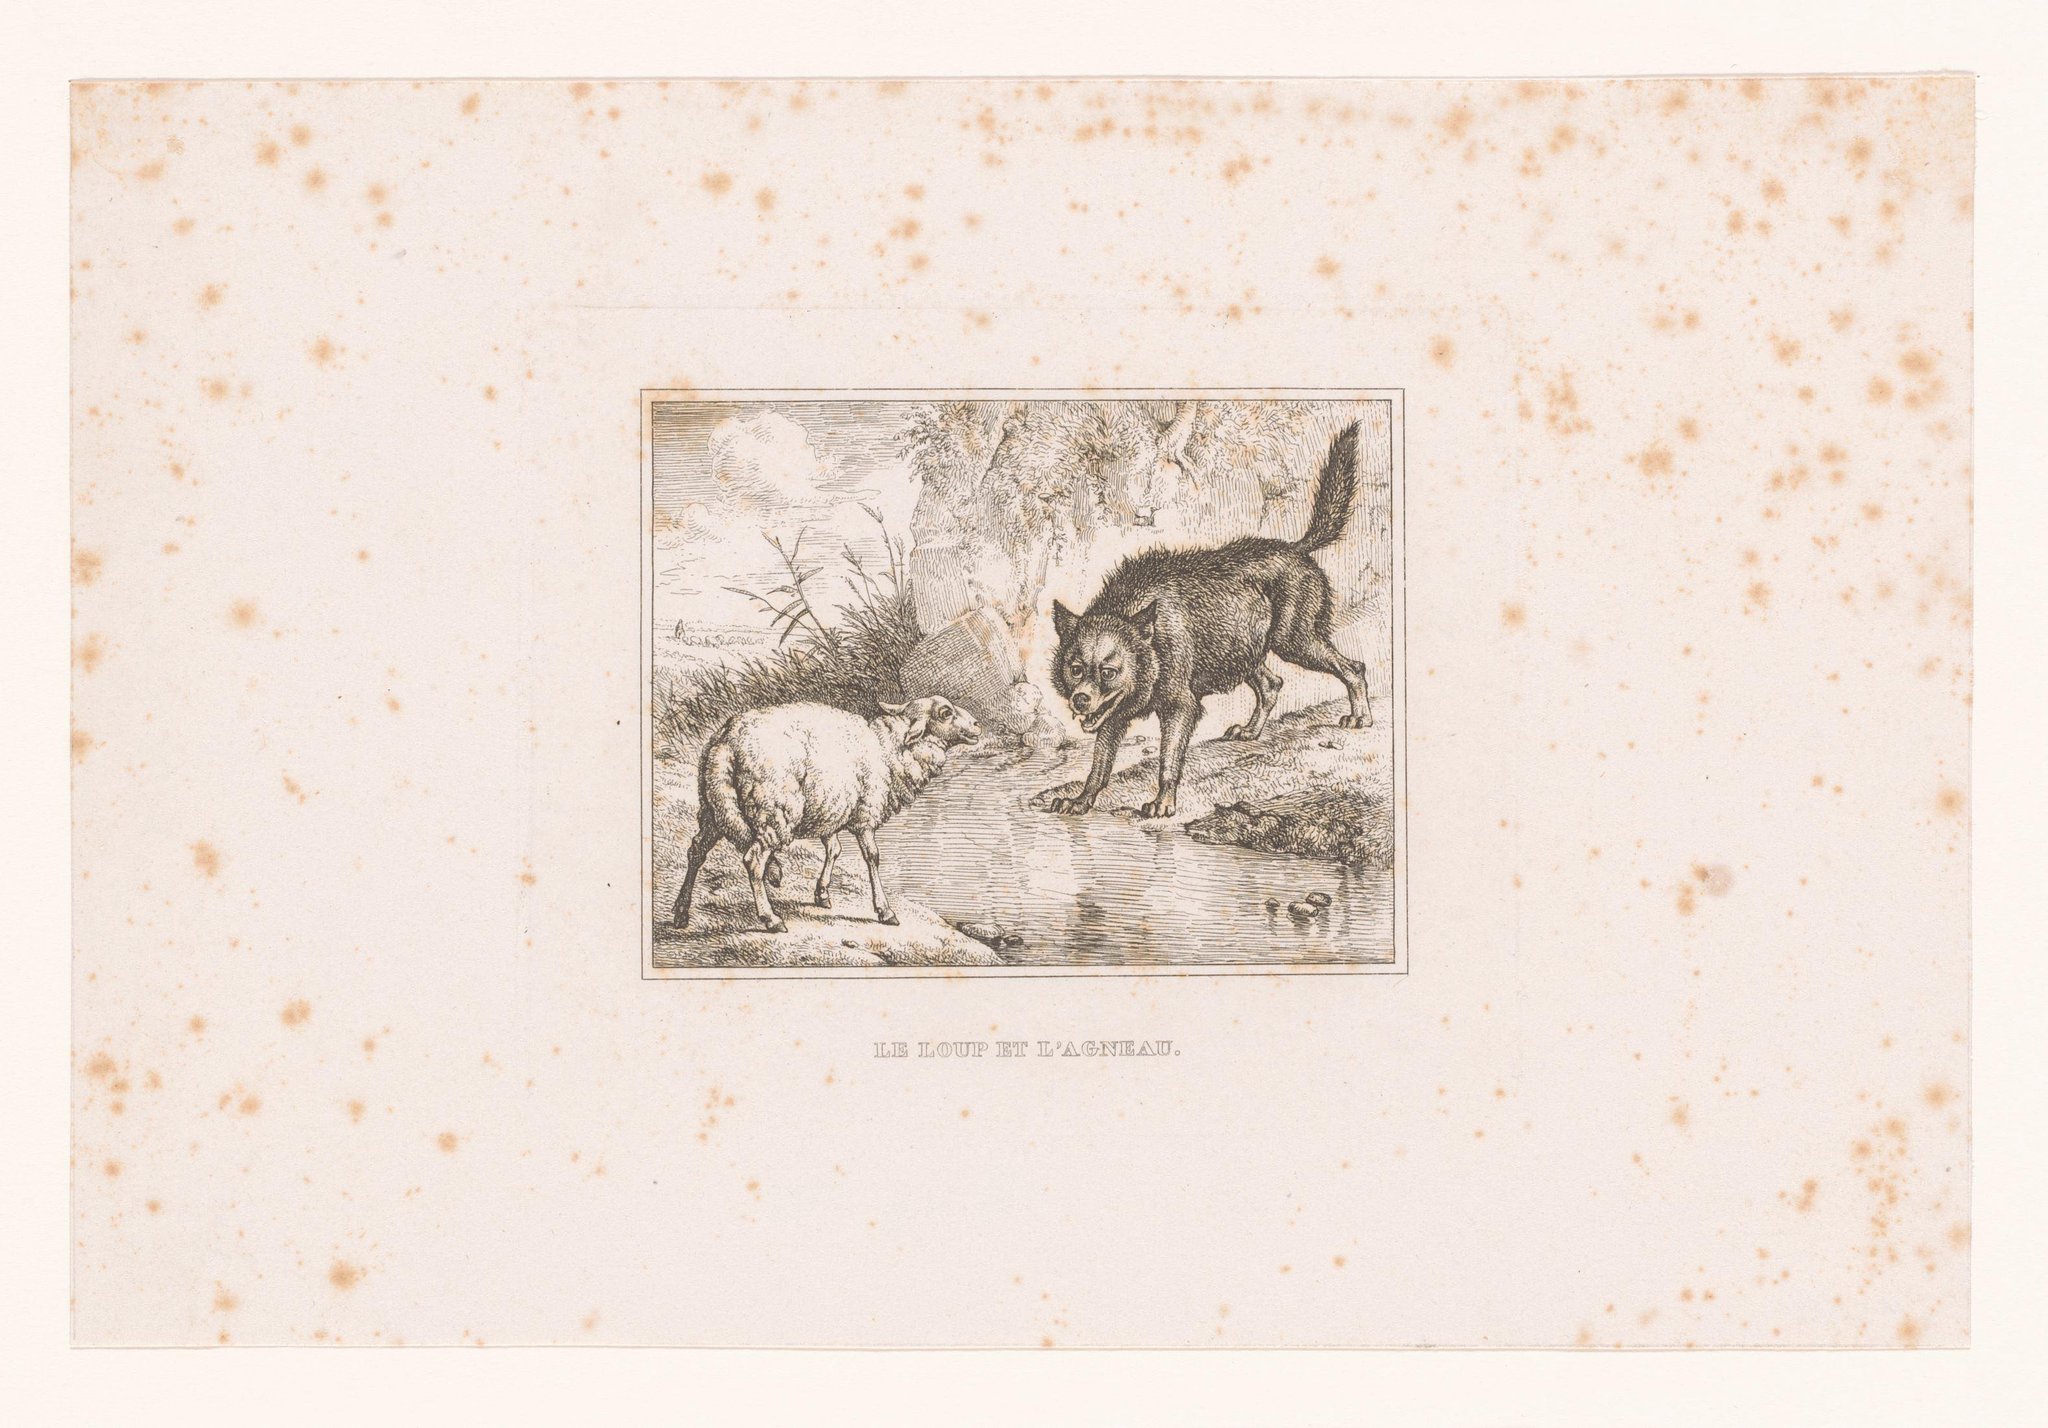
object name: print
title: Fabel van de wolf en het lam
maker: eugène verboeckhoven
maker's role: draughtsman, painter, print maker, printer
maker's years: 1798-1881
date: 1808-1881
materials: paper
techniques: etching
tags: lamb, fables, beasts of prey, predatory animals: wolf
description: Prent maakt deel uit van een serie van acht prenten met scènes uit de fabels van Jean de La Fontaine.